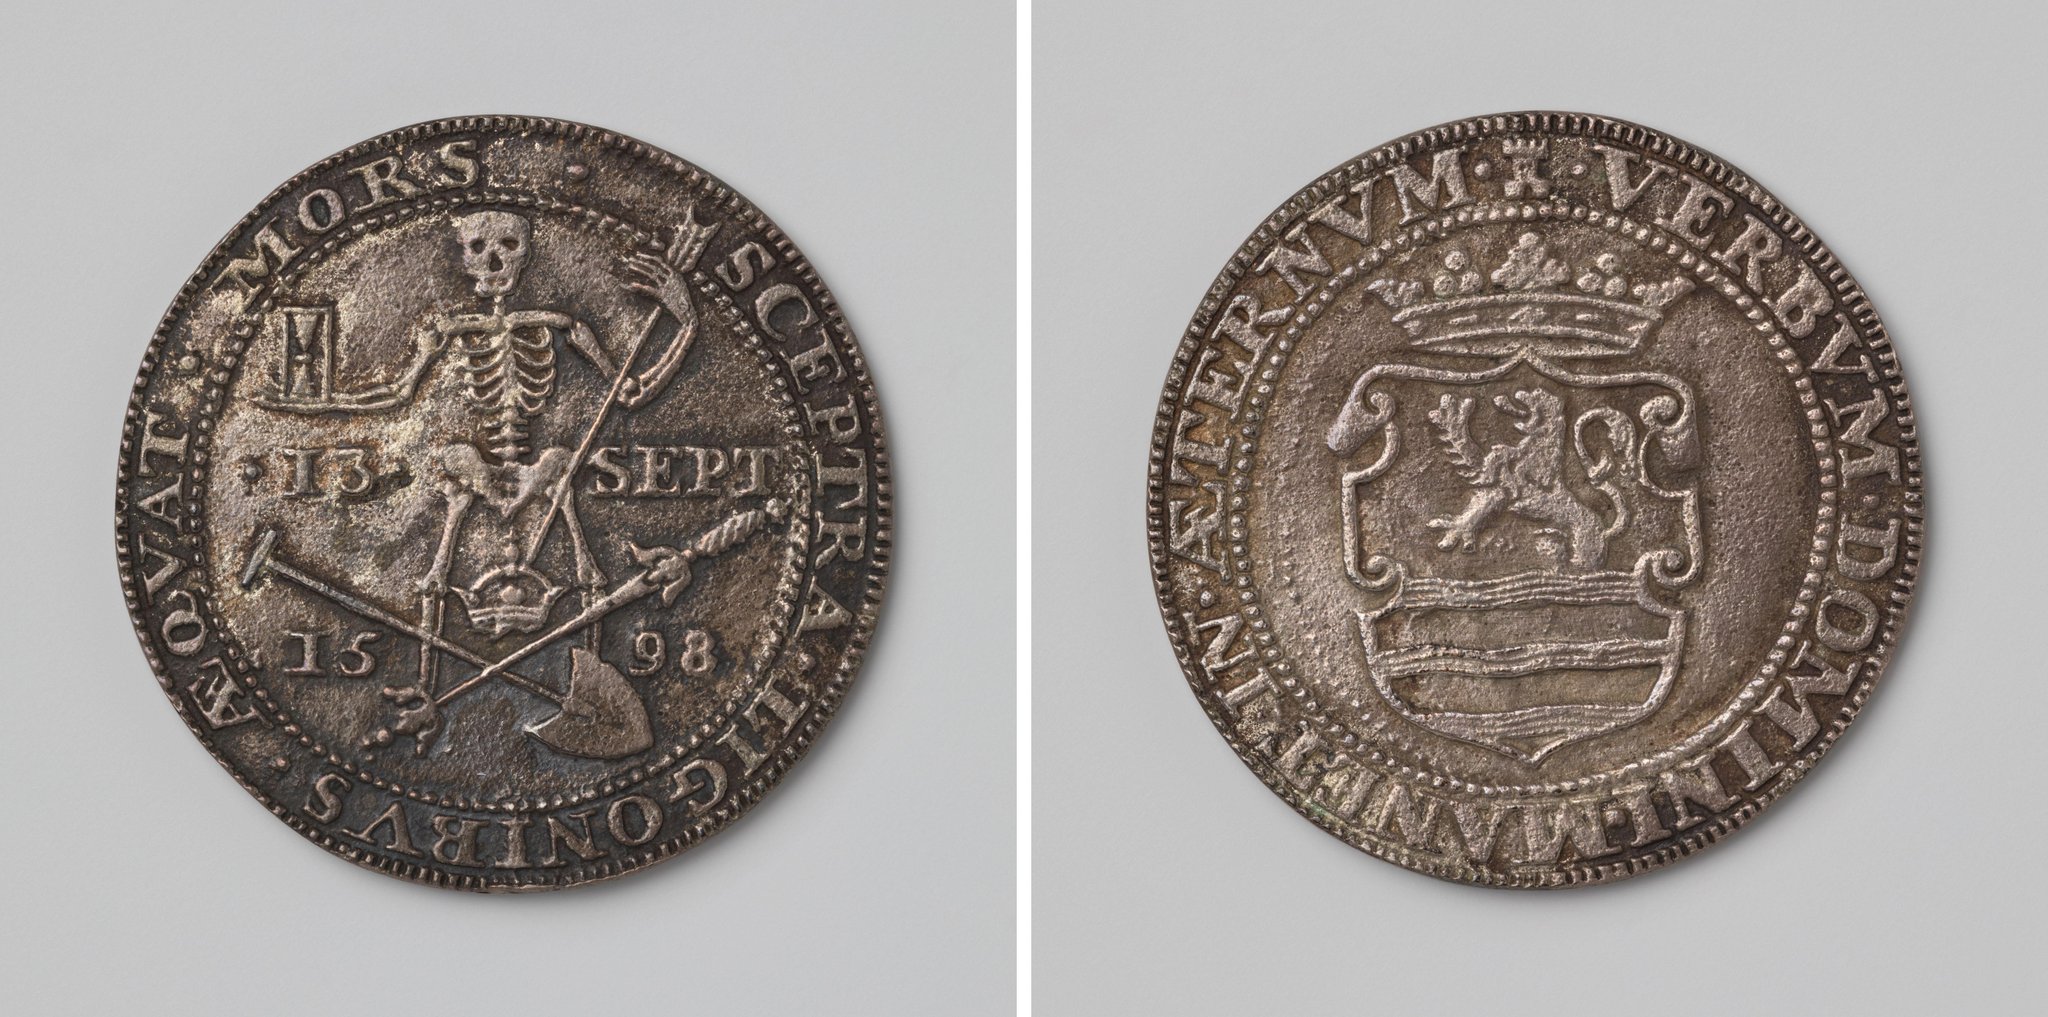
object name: jeton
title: Overlijden van Filips II, koning van Spanje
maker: Anonymous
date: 1598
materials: silver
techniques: striking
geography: middelburg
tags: philip ii of spain, zeeland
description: Zilveren penning. Voorzijde: geraamte, voorstellende de Dood, houdt in rechterhand een zandloper en in linkerhand een pijl, waaraan kroon is bevestigd, boven gekruiste scepter en spade tussen opschrift binnen omschrift. Keerzijde: gekroond wapenschild binnen omschrift